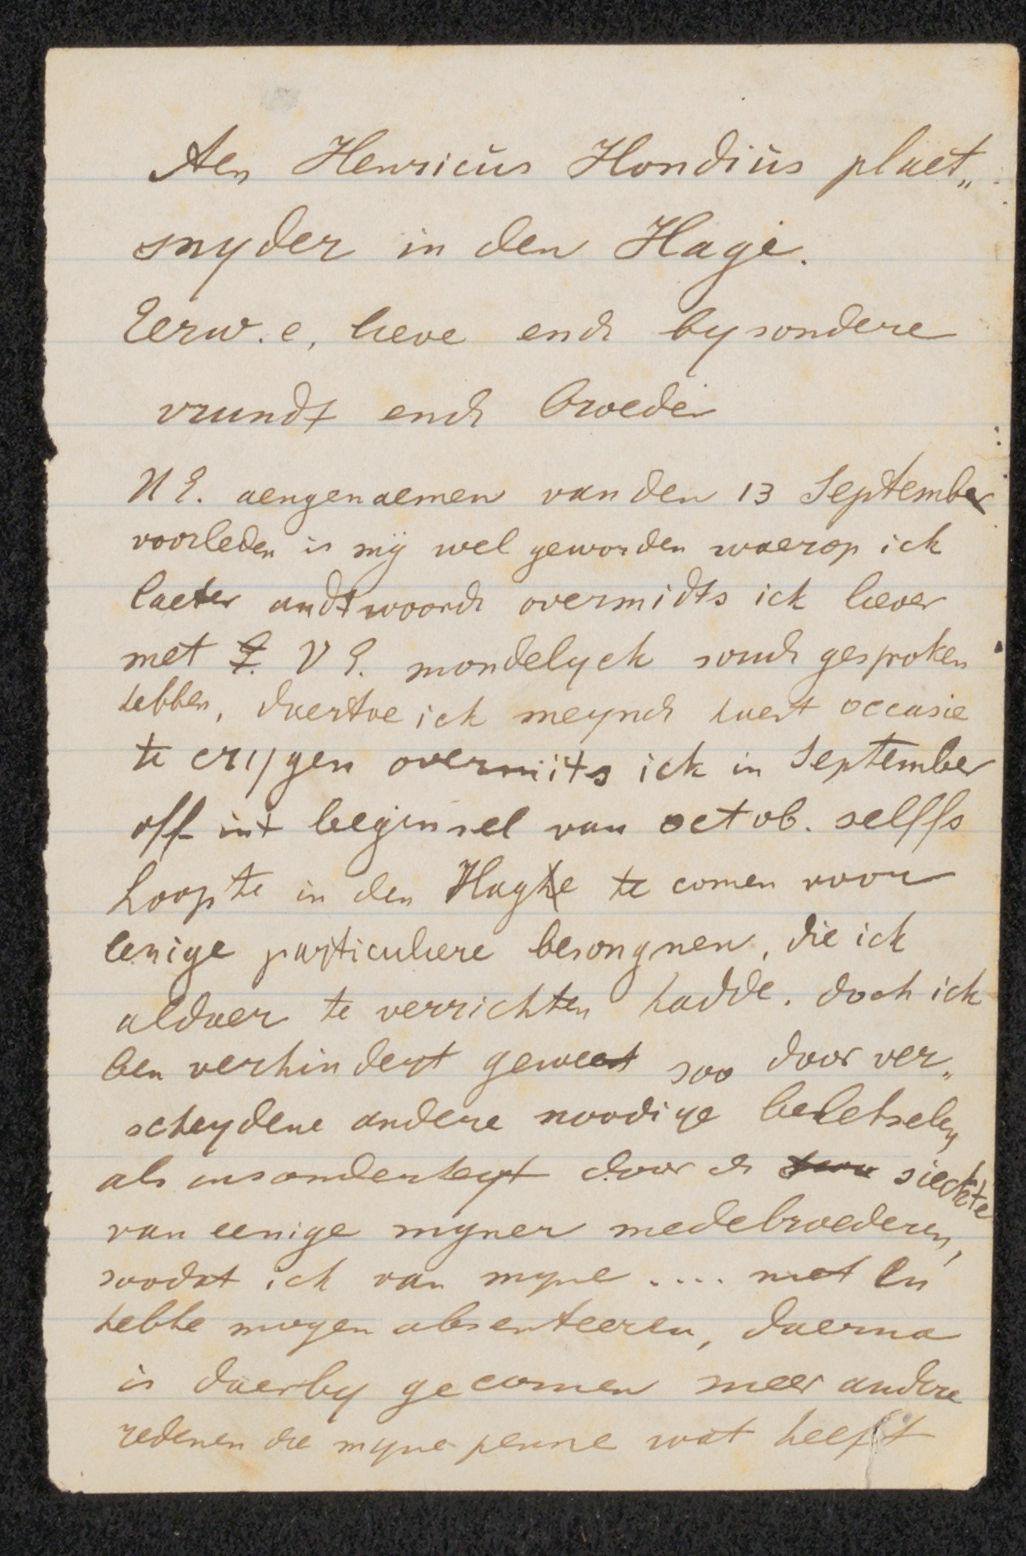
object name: letter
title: Brief aan Henricus Hondius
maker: Anonymous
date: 1607-1651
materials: ink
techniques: pen, writing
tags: publisher, henricus hondius, passions, emotions, affections, the graphic arts, the hague